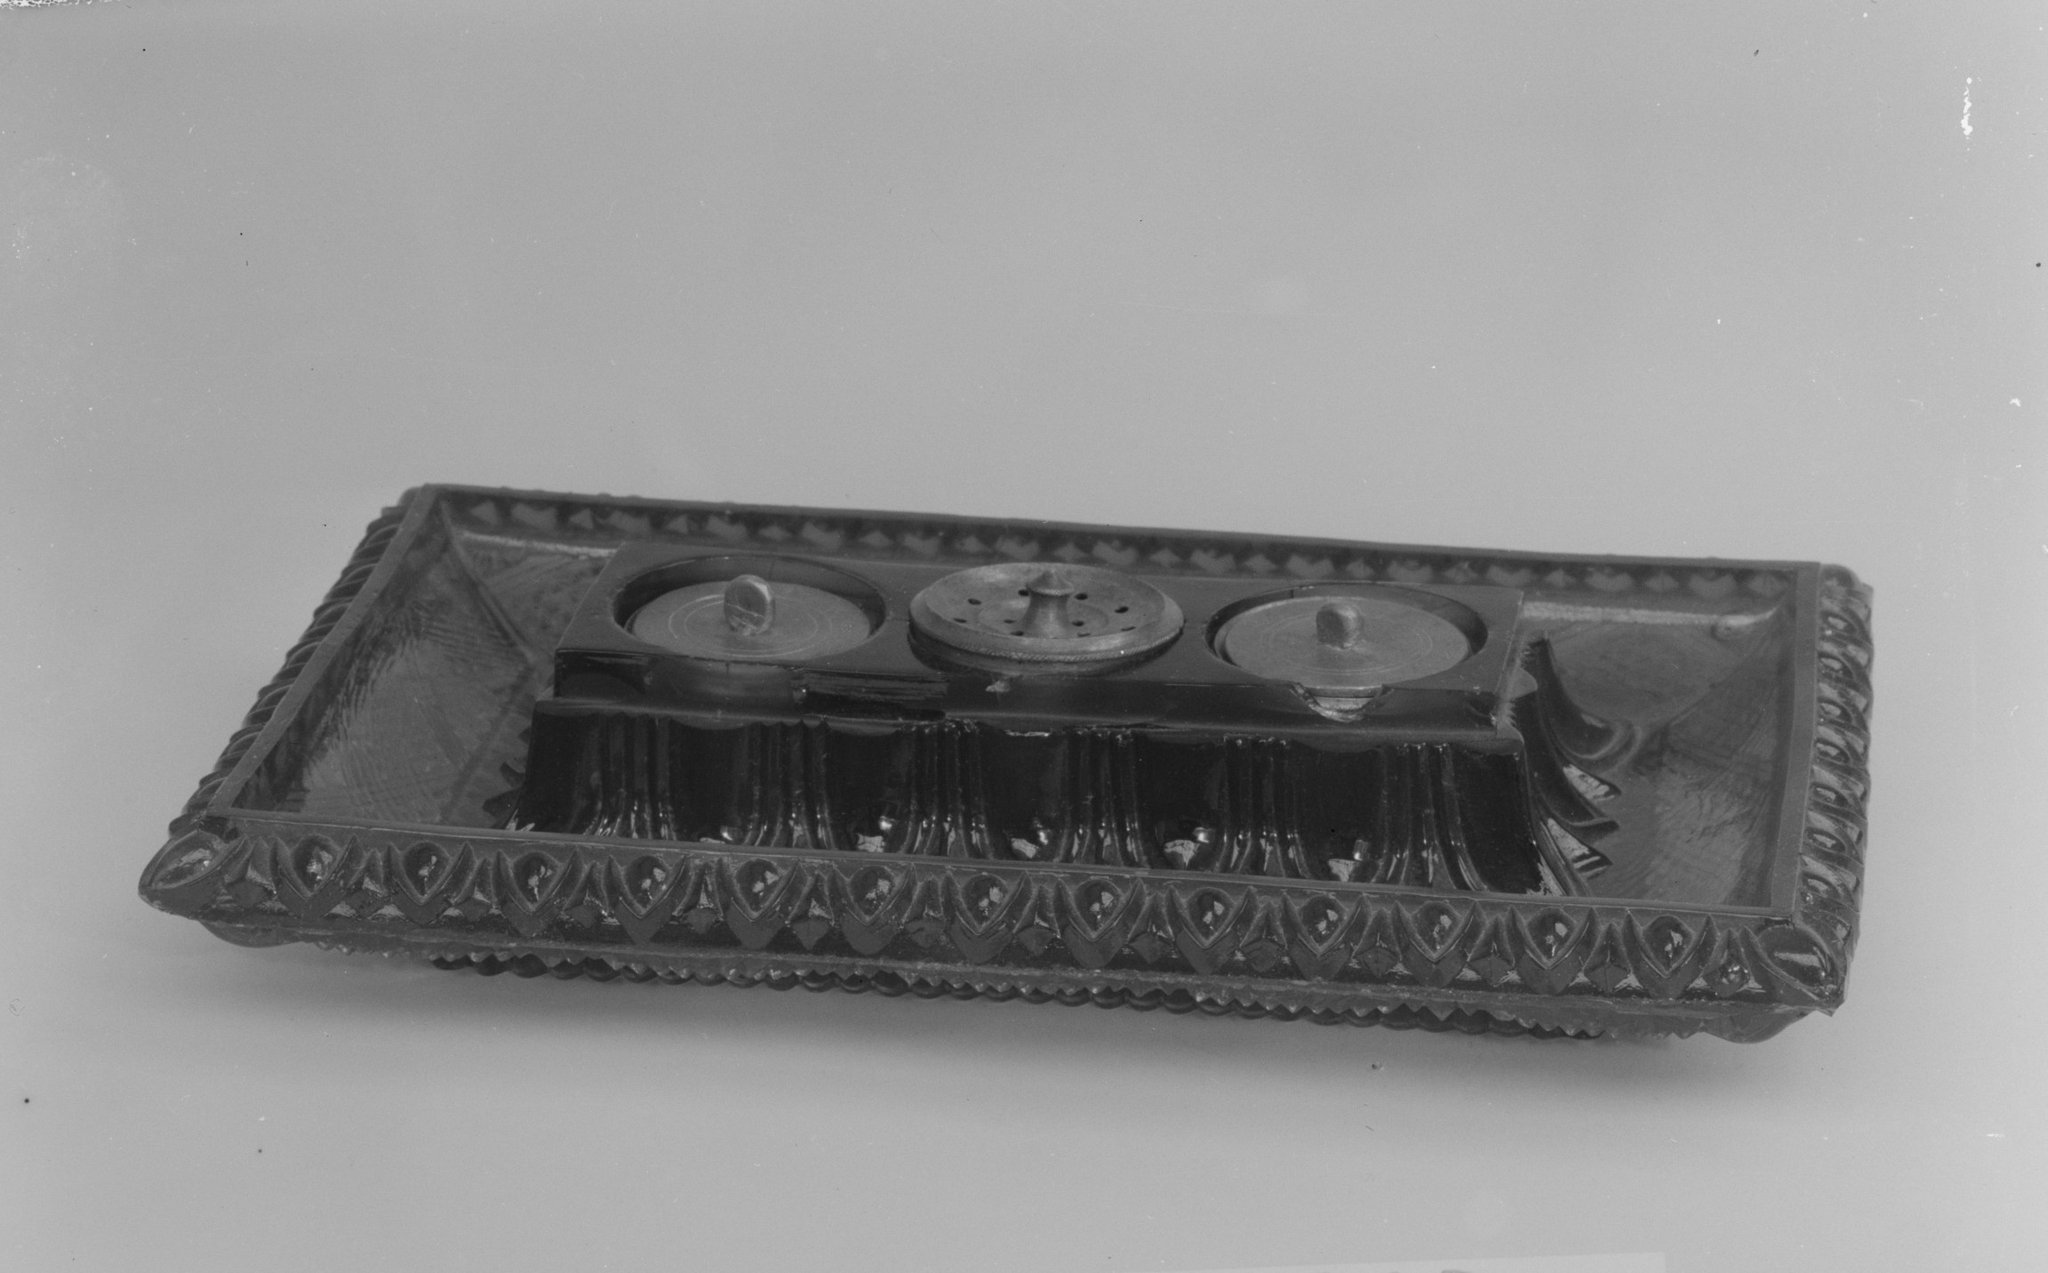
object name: inkstand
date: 1800-1900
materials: glass, pewter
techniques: pressed